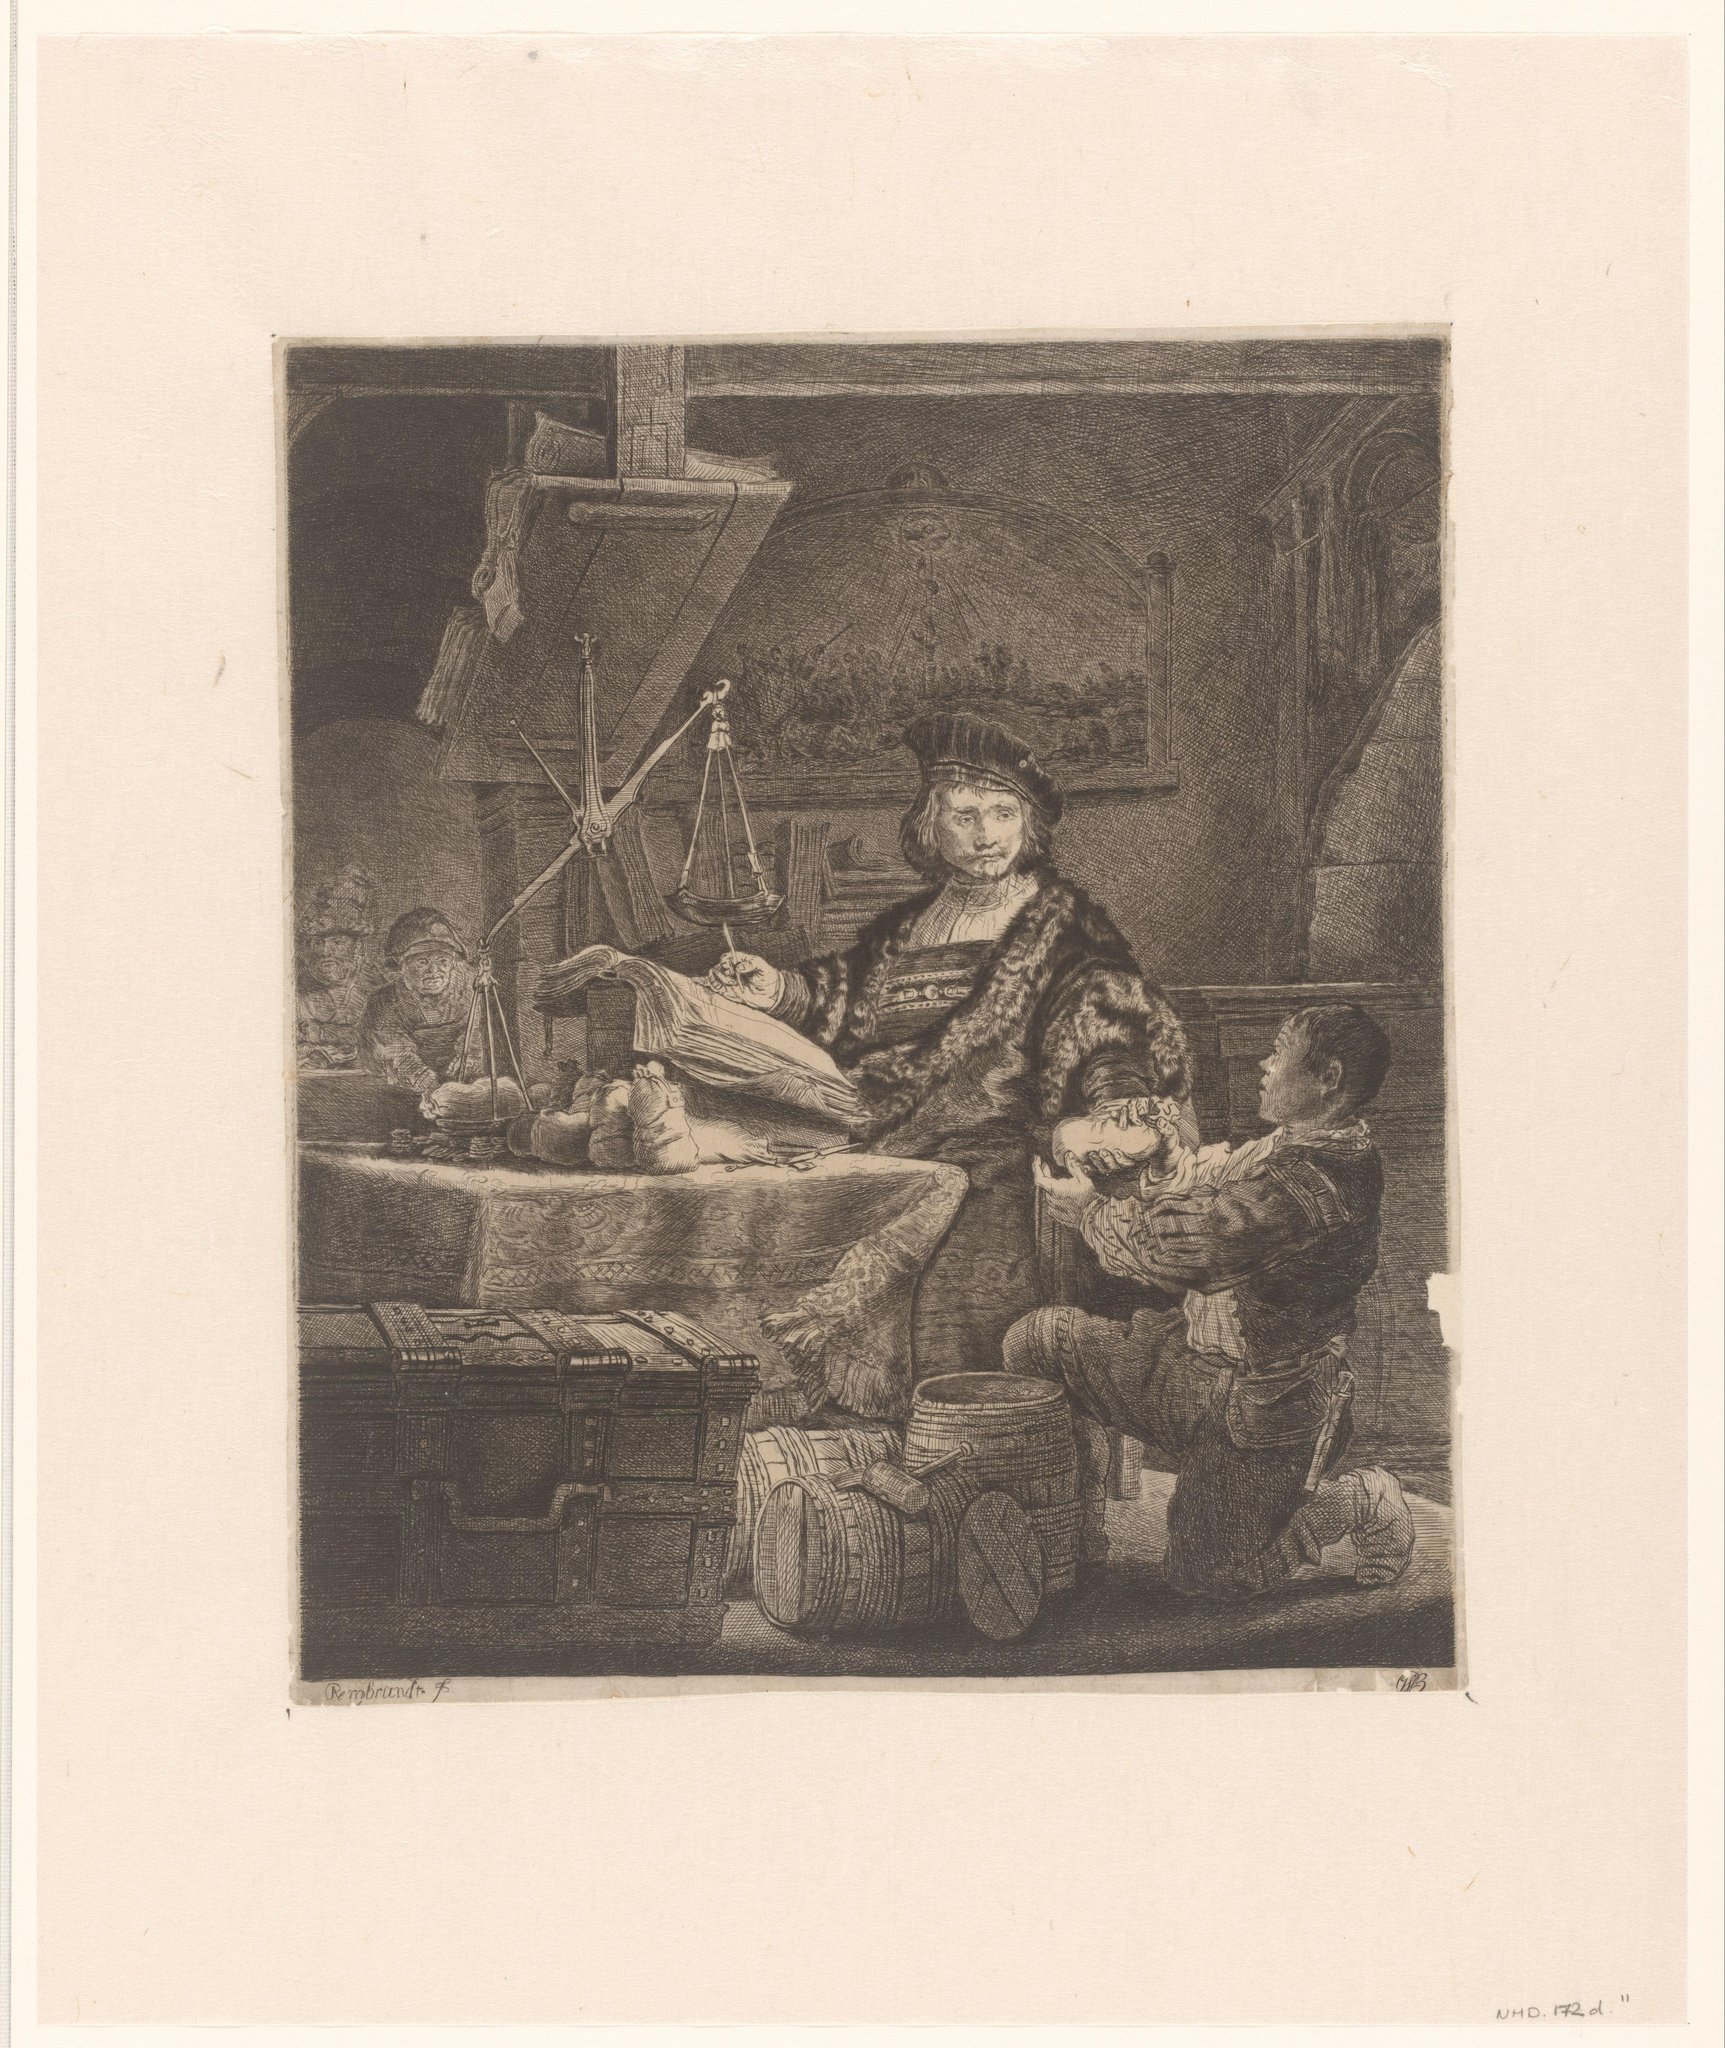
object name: print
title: Jan Uytenbogaert, 'The goldweigher'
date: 1733-1810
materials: paper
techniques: etching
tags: historical persons, dealing in money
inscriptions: collector's mark: Lugt 2760, stamp, collector's mark: Lugt 2228